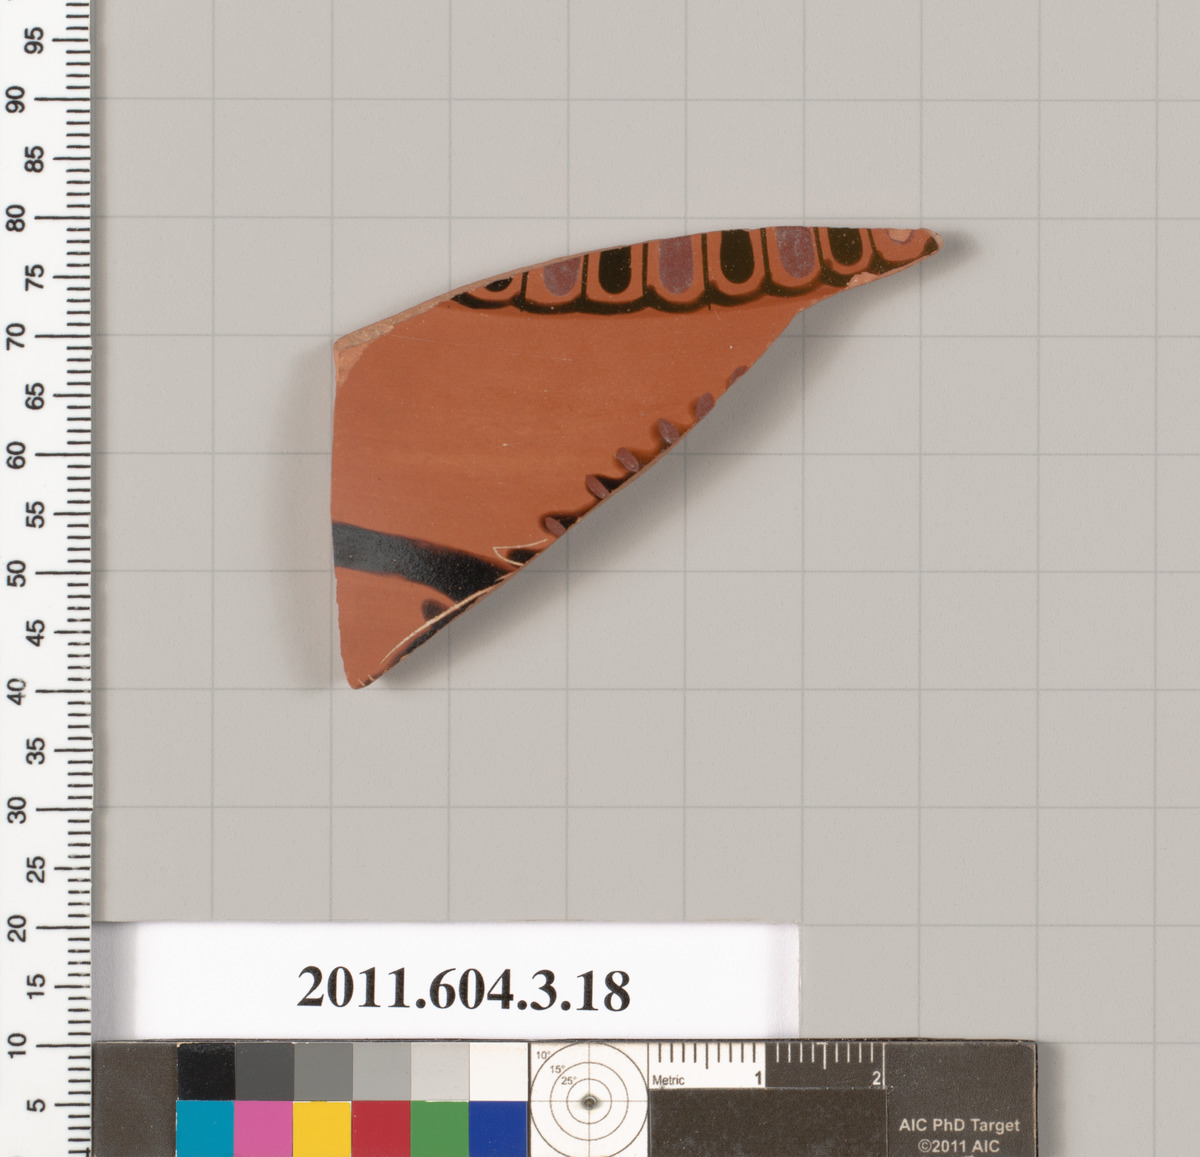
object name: neck amphora fragment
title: Terracotta fragment of a neck-amphora (jar)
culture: greek, attic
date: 530-520 BCE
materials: terracotta